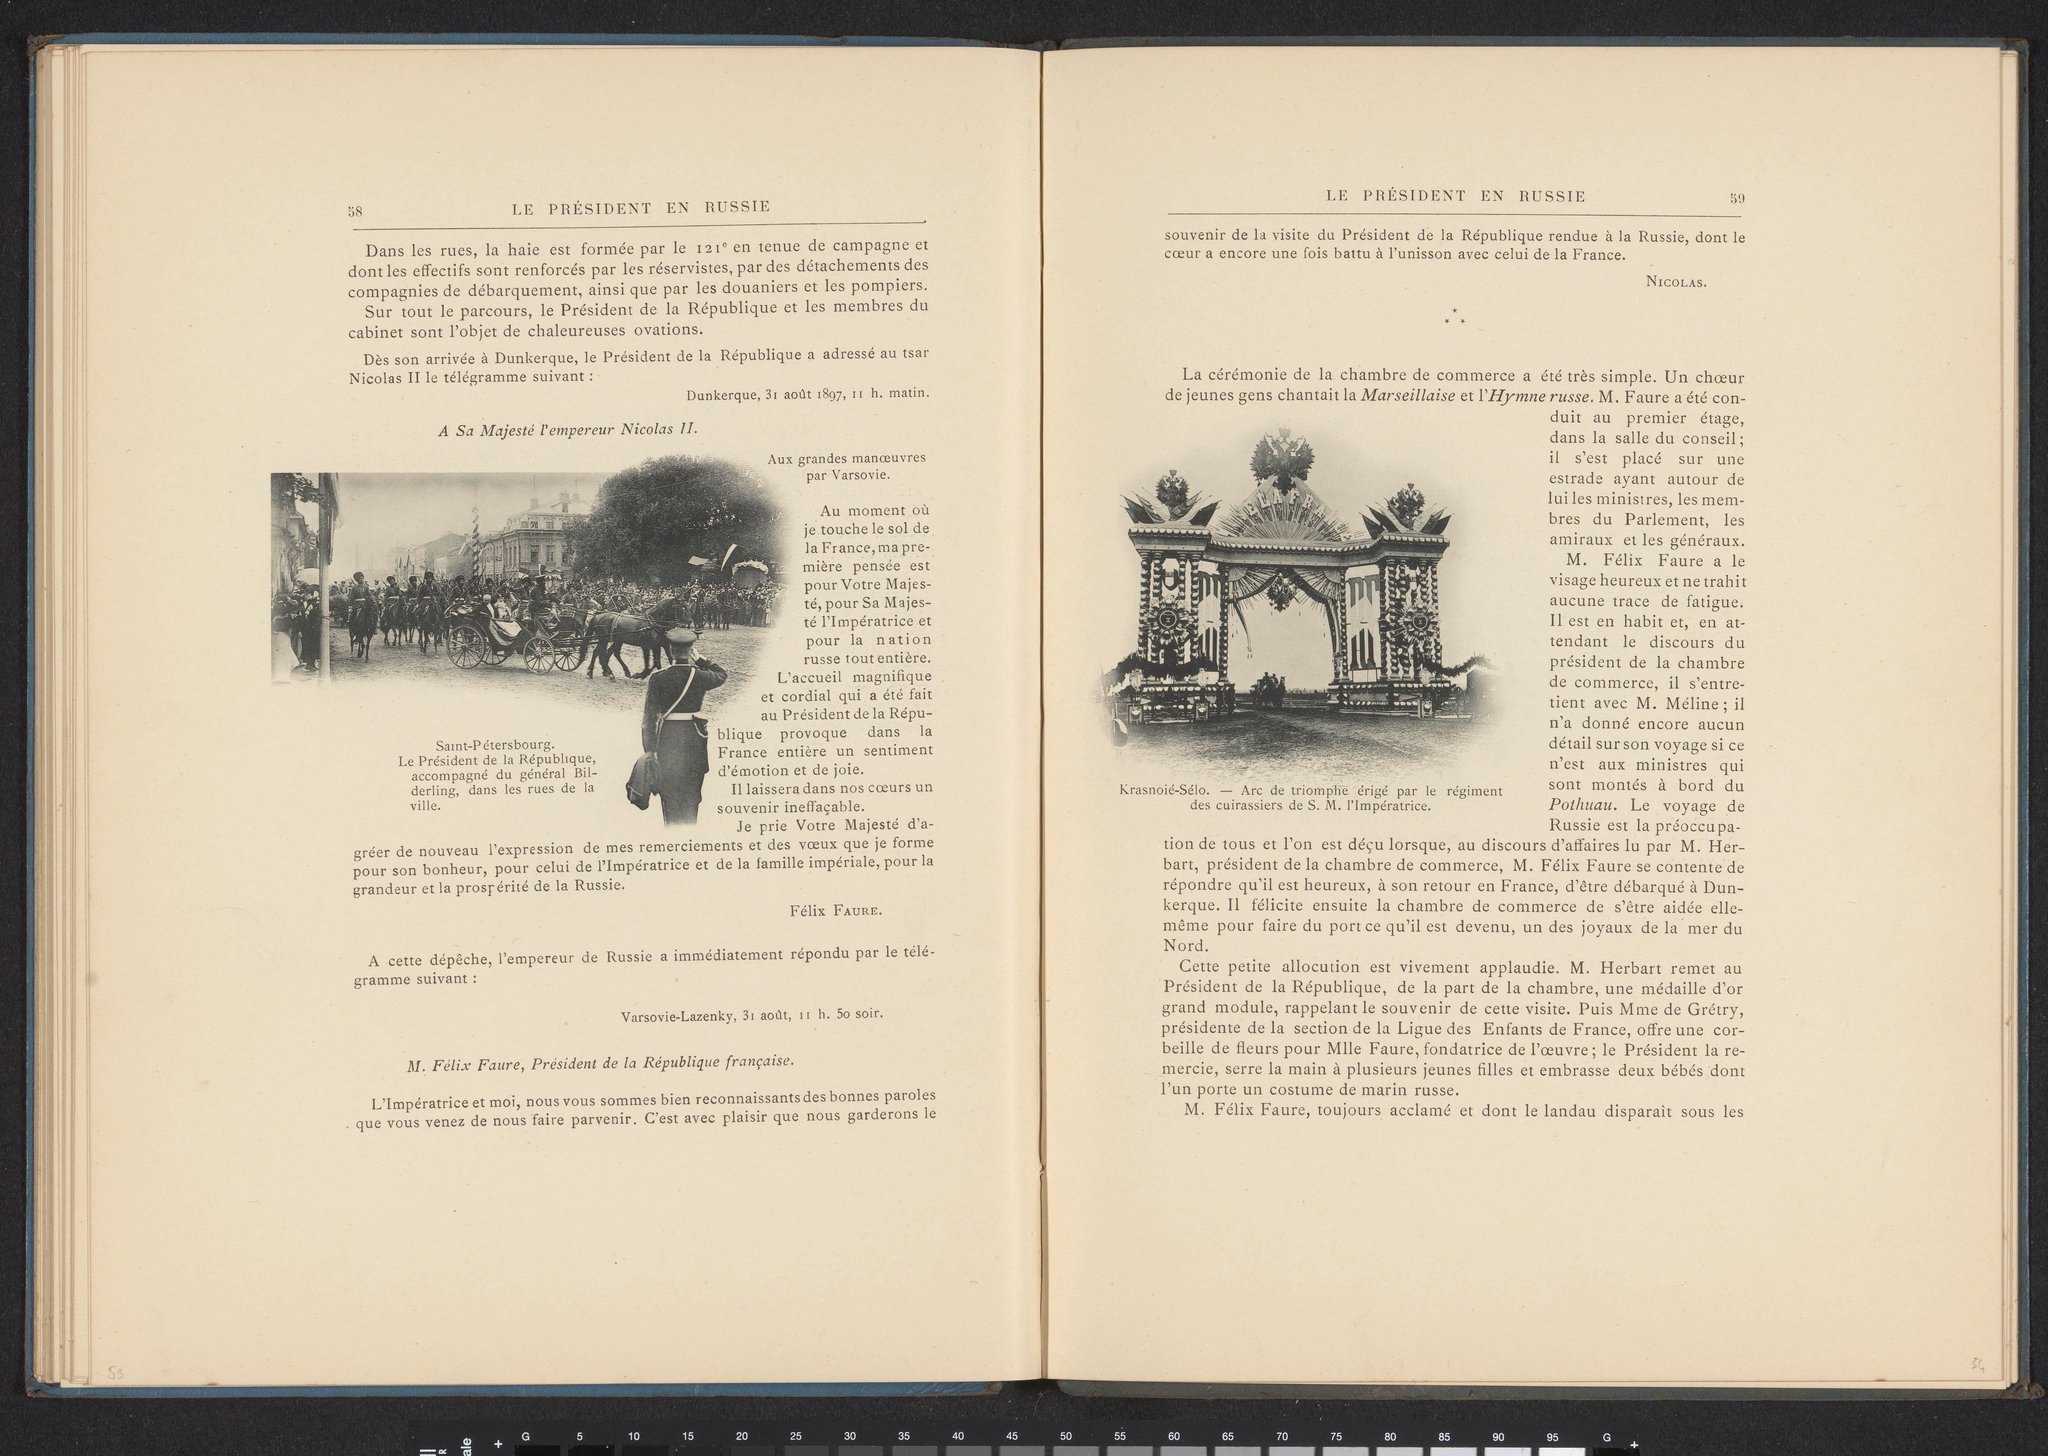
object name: page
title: Triomfboog te Krasnoye Selo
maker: Anonymous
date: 1897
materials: paper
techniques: photograph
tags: triumphal arch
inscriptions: inscription: ‘Krasnoié-Sélo-(...) l'Imperatrice.’